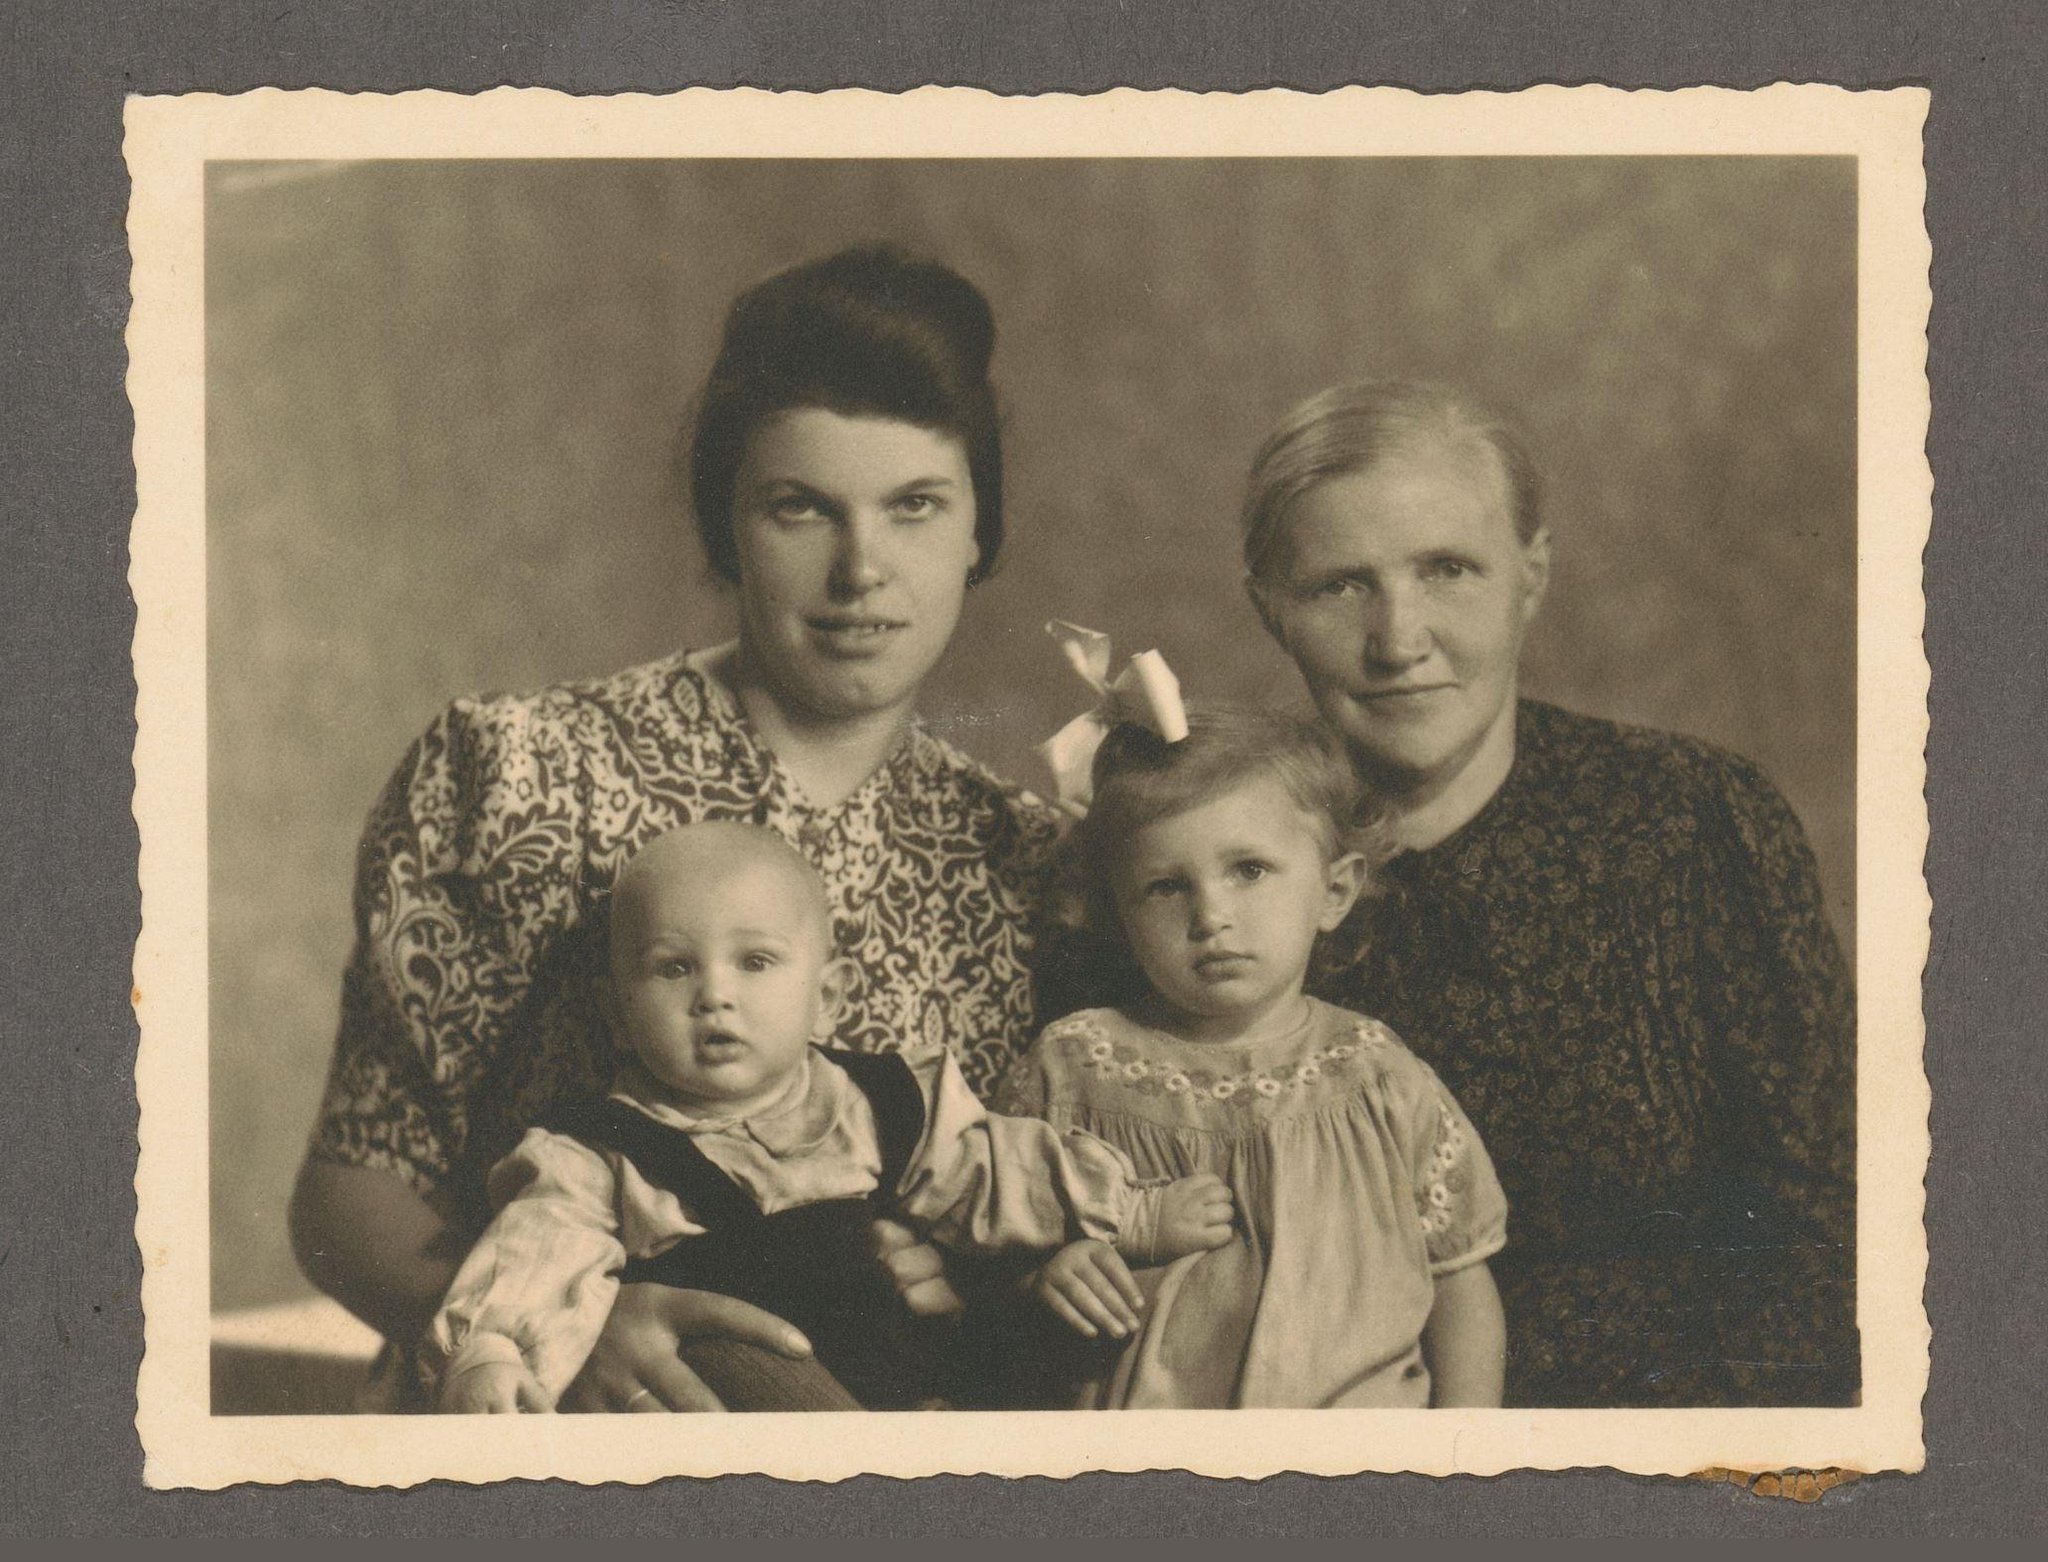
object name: album leaf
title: Twee vrouwen met kinderen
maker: Anonymous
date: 1930-1950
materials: paper, photographic support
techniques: gelatin silver print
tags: toddler, adult woman, infant, baby